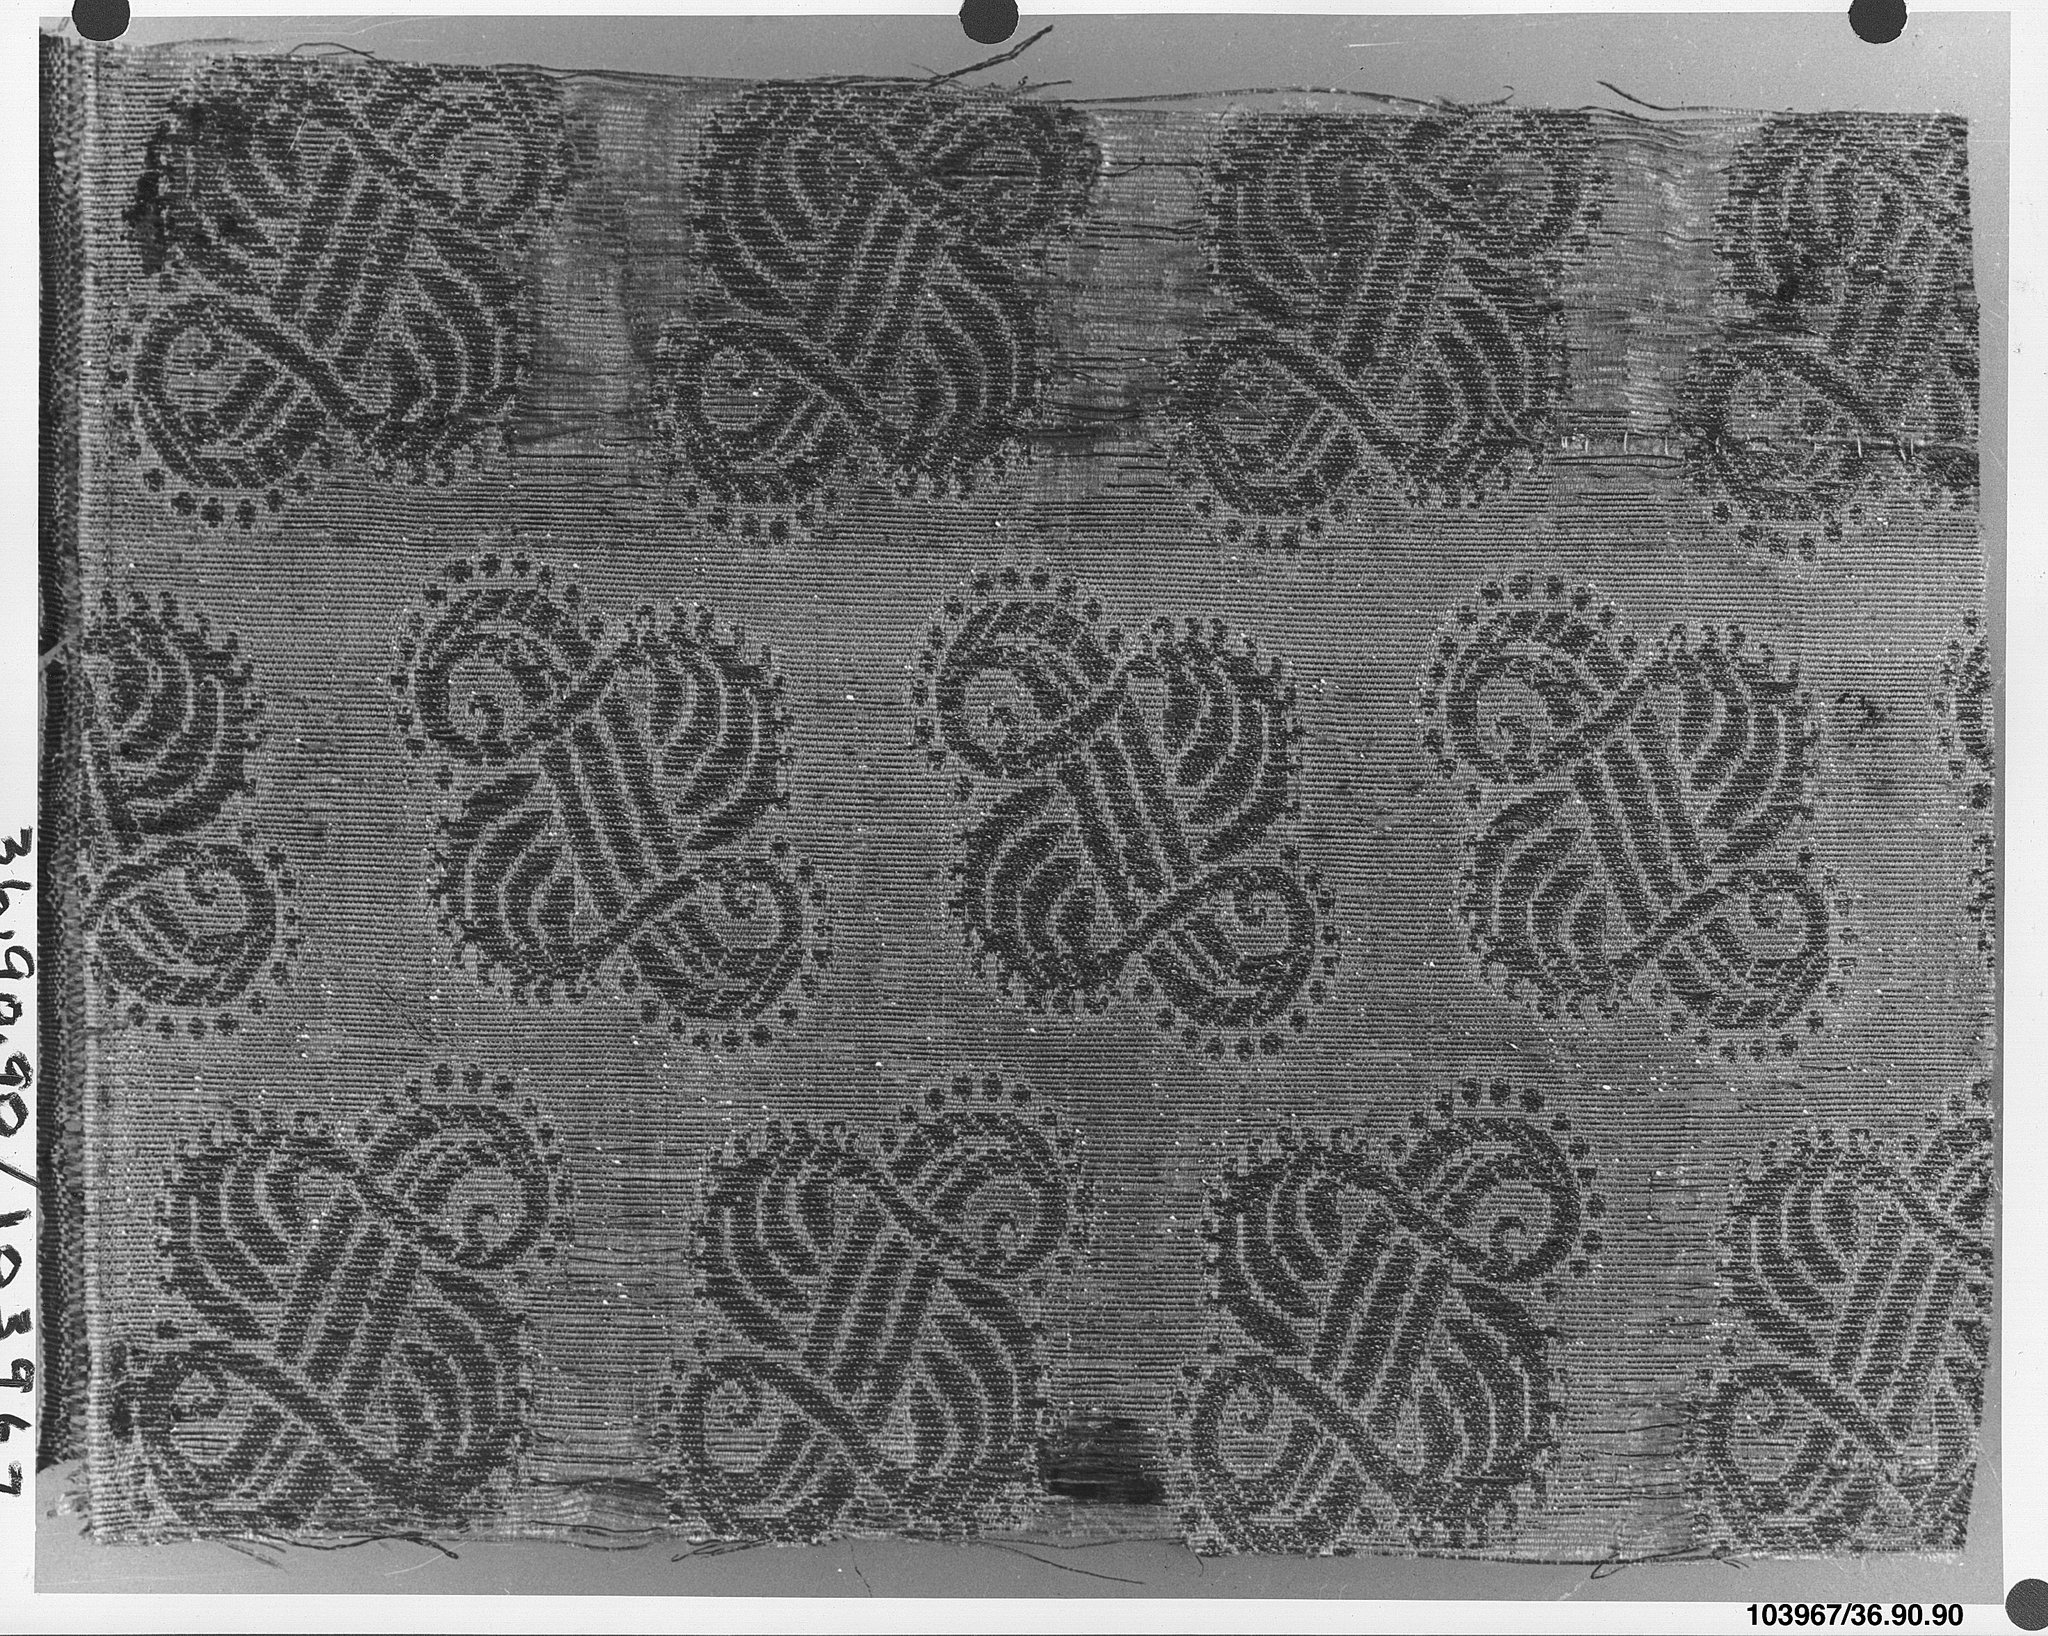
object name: piece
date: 1501-1700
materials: metal thread, silk